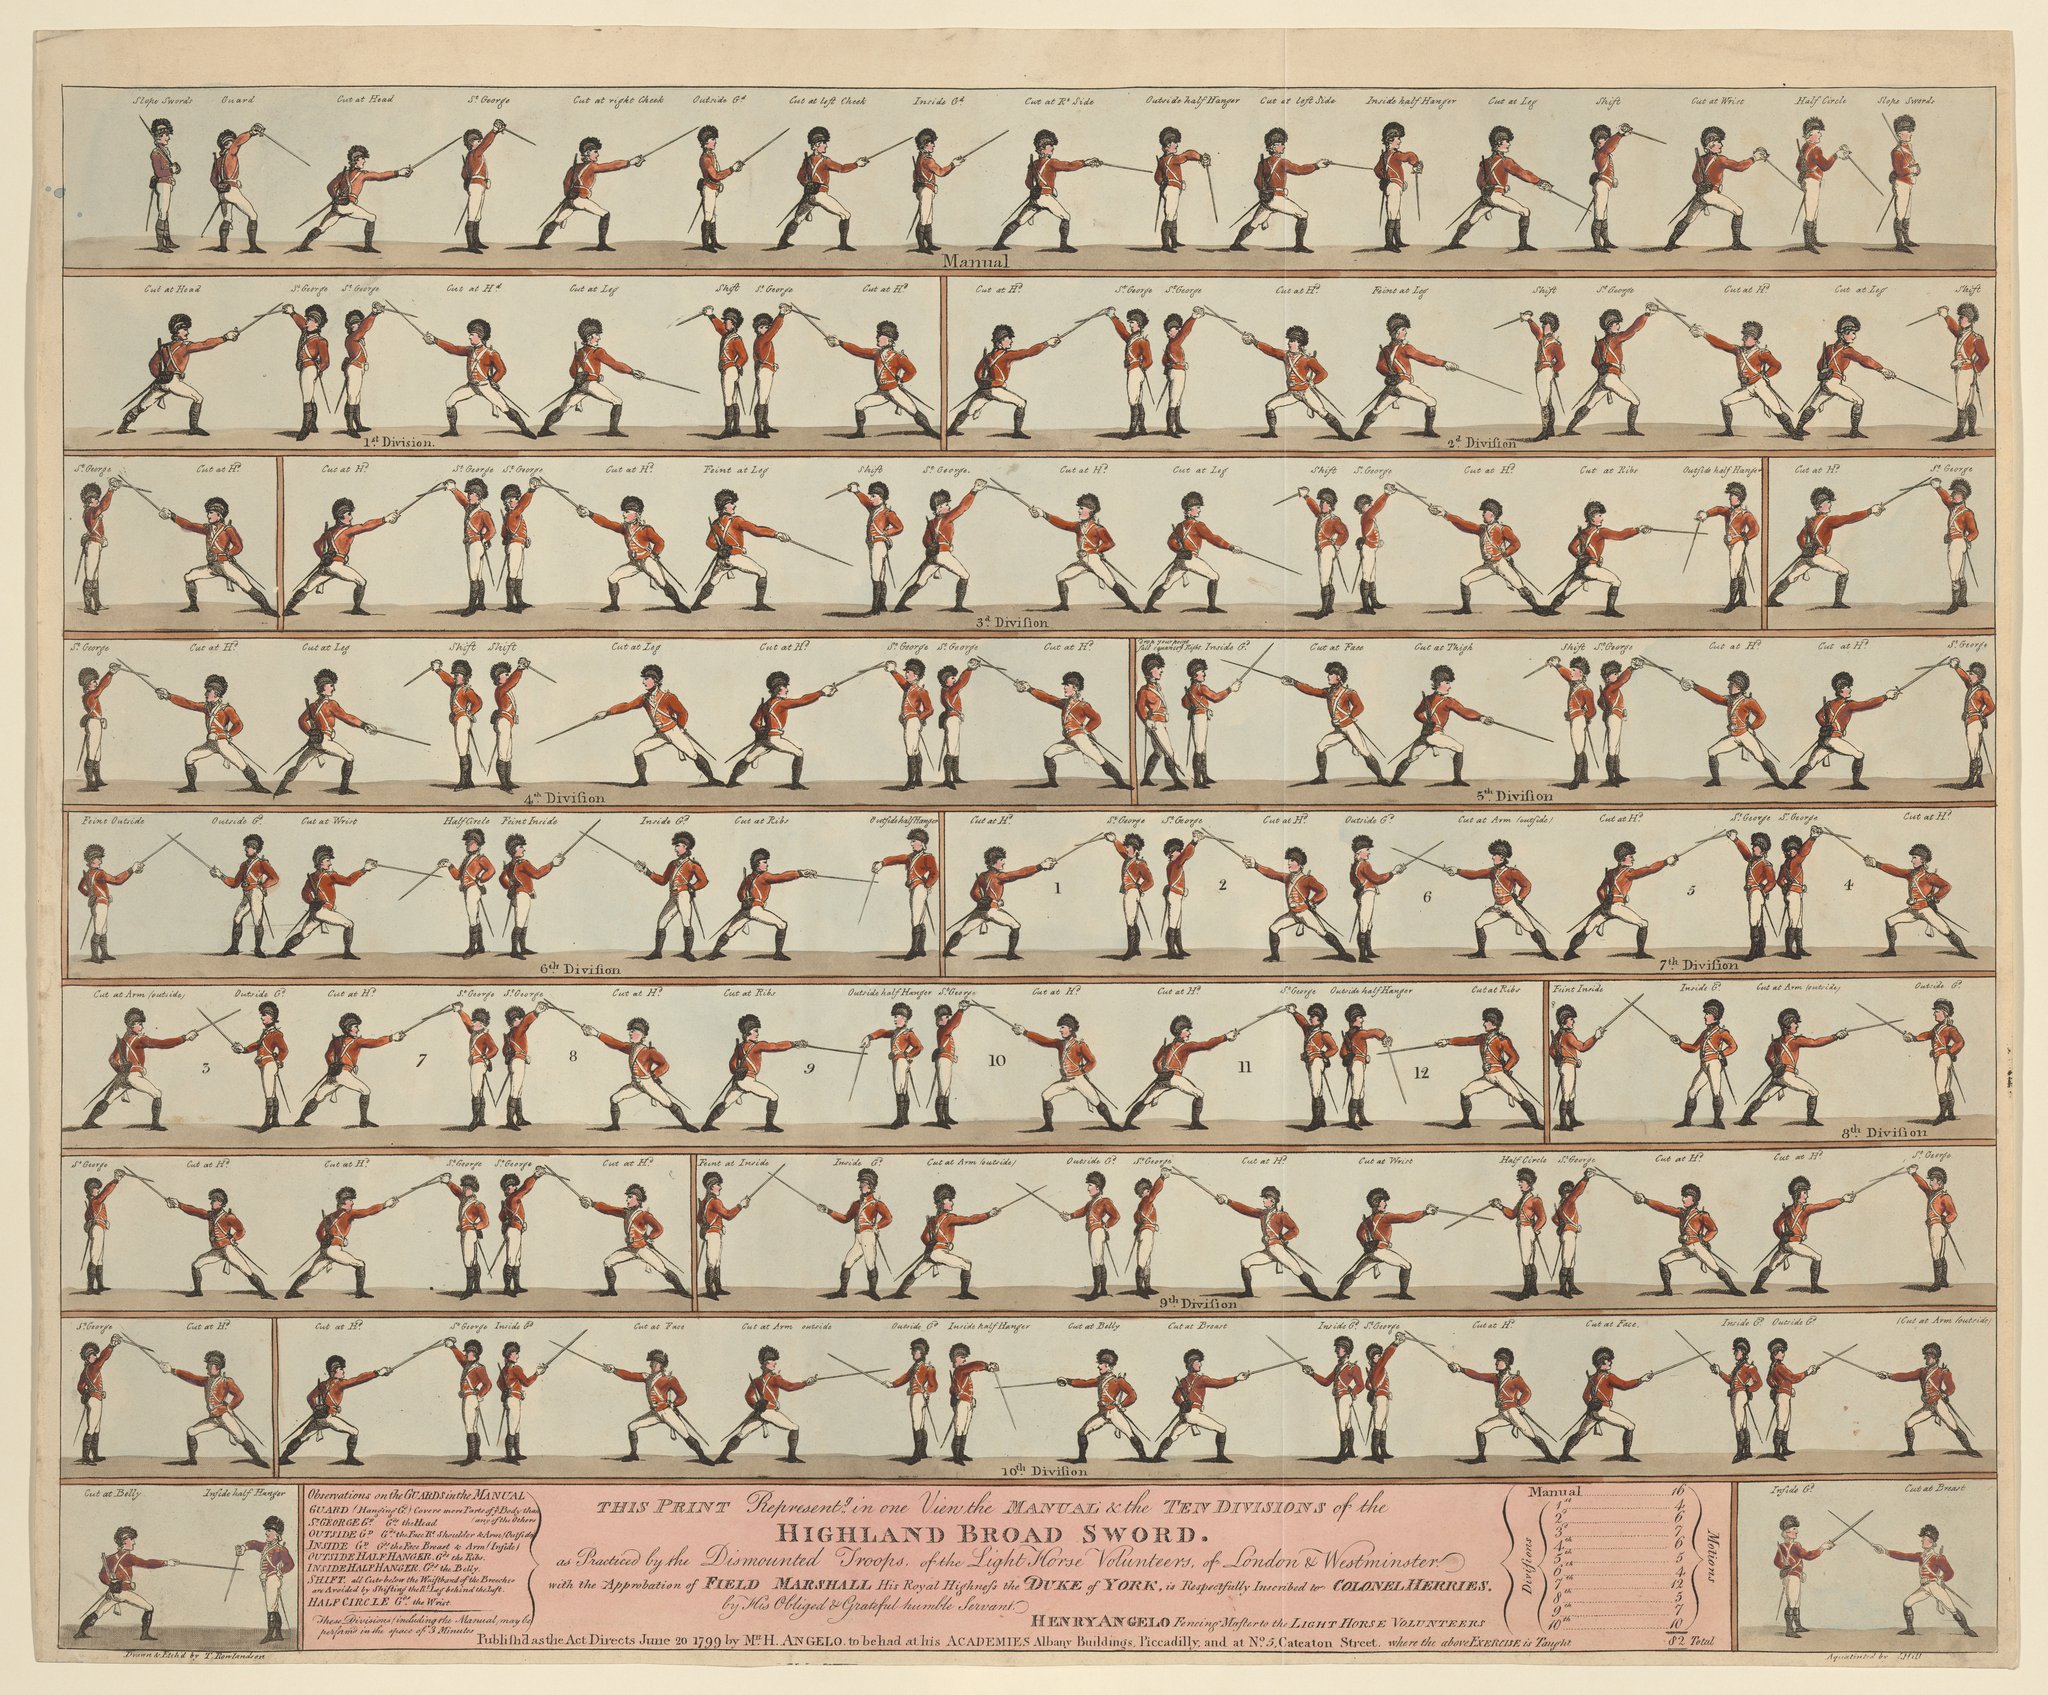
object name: print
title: The Manual and the Ten Divisions of the Highland Broad Sword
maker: thomas rowlandson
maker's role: artist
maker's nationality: british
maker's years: 1757-1827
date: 1799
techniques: aquatint, etching